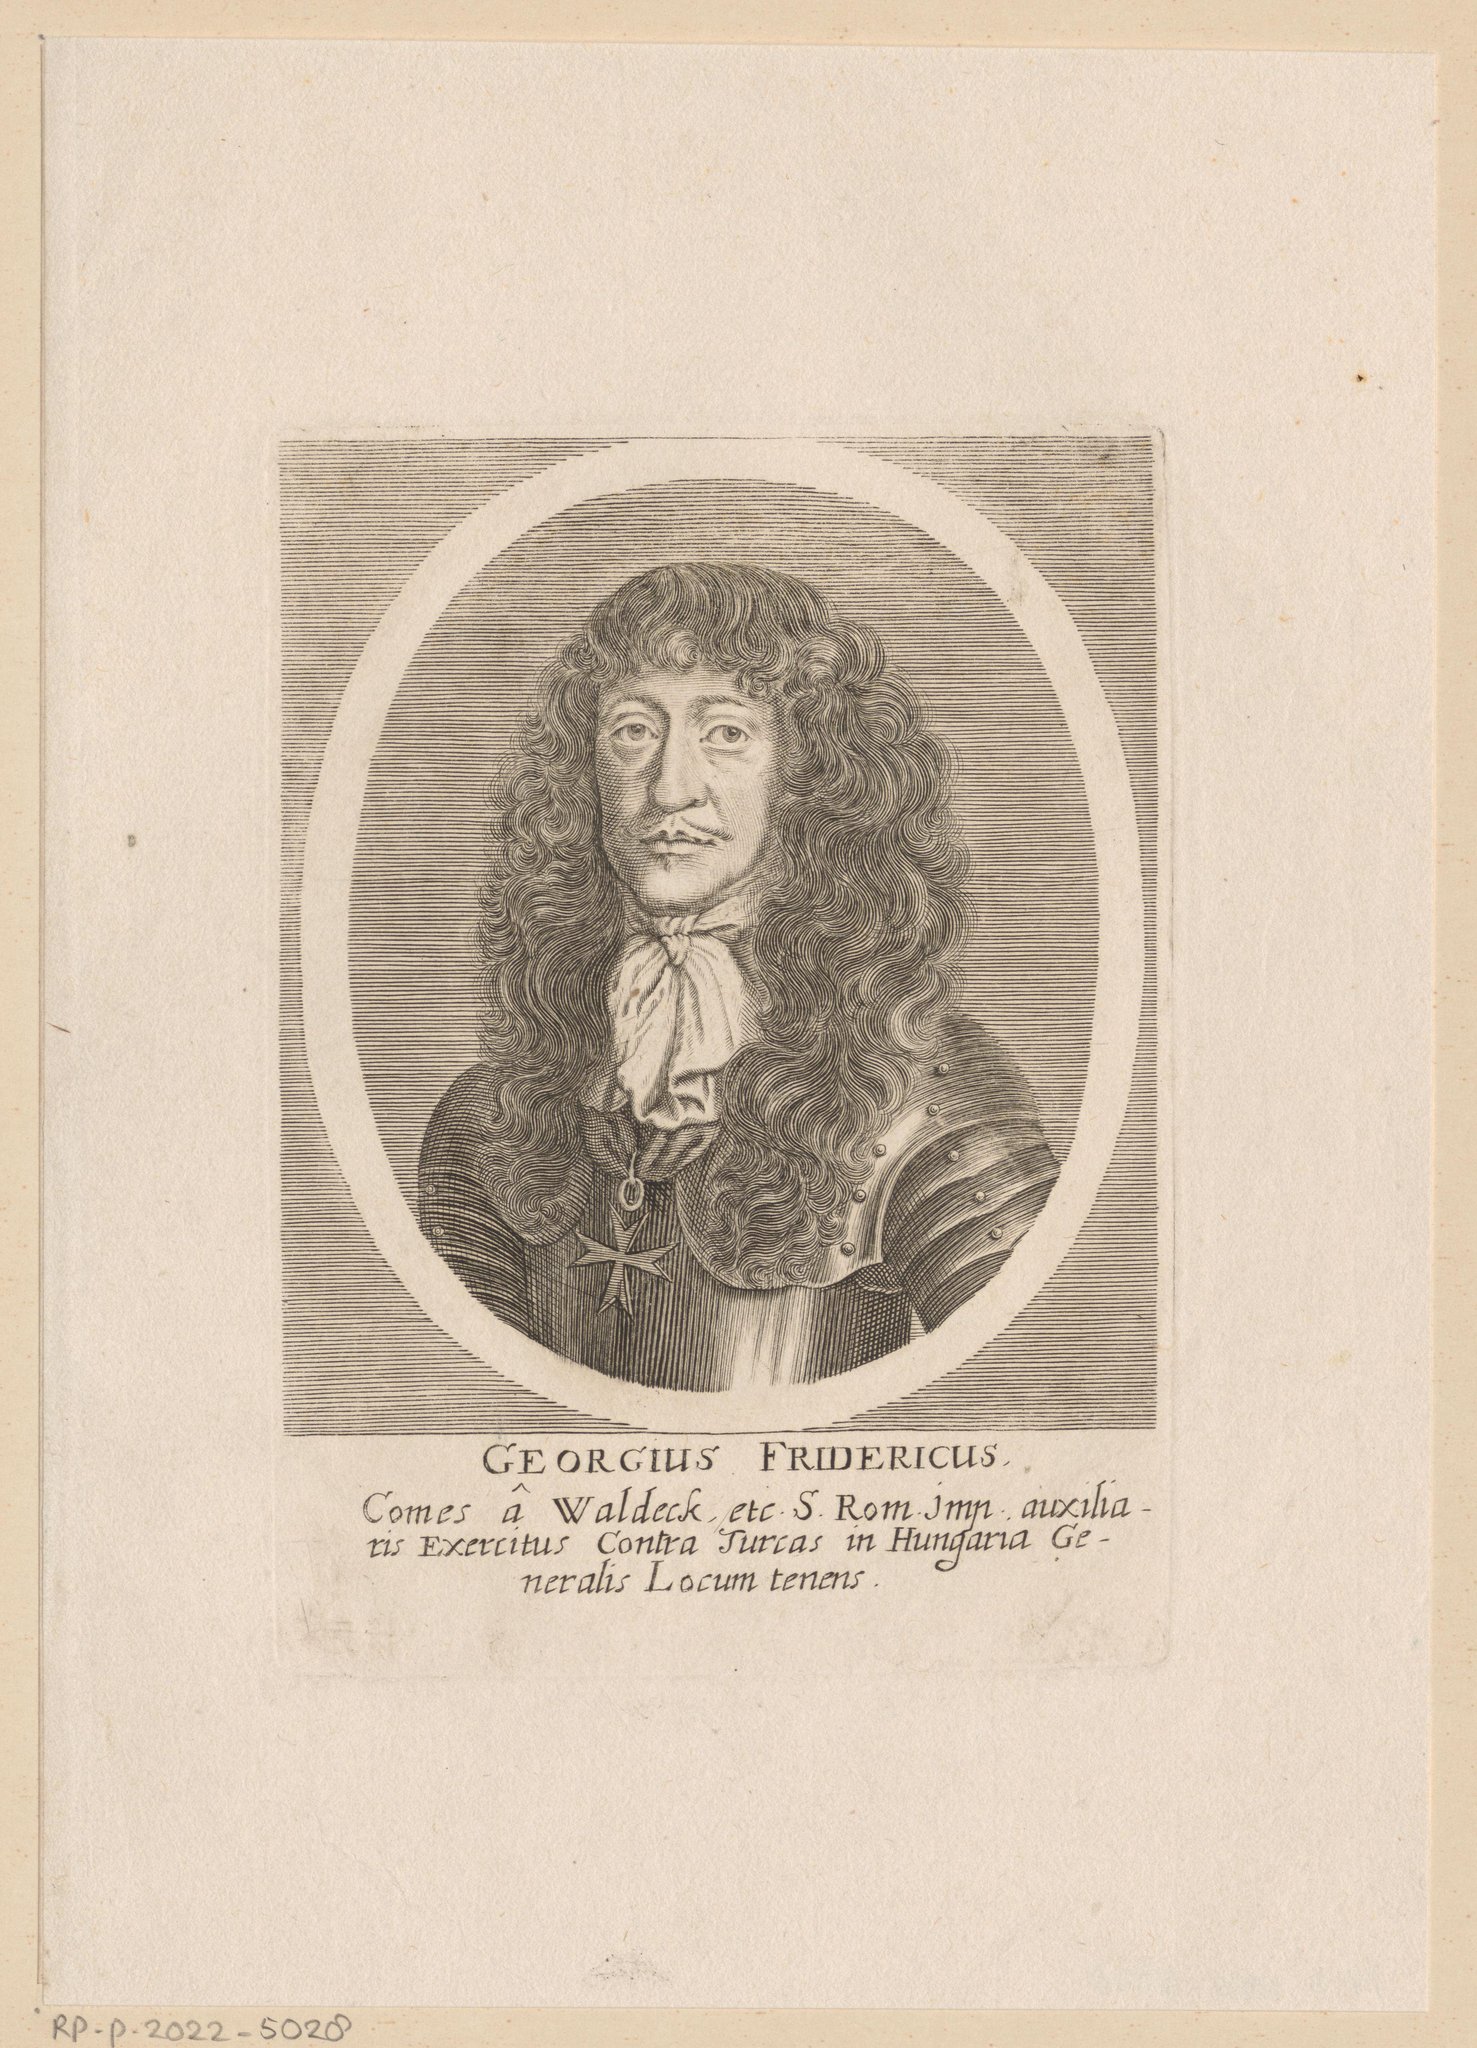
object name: print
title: Portret van Georg Friedrich prins van Waldeck-Eisenberg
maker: matthäus merian (ii)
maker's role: painter, print maker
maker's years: 1621-1687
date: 1698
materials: paper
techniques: engraving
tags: commander-in-chief, general, marshal, armour, prince, historical persons, medals and other marks of military honour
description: Prent waarschijnlijk uit: Theatrum Europaeum. Frankfurt am Main: erven Matthäus Merian, 1698, dl. 13.